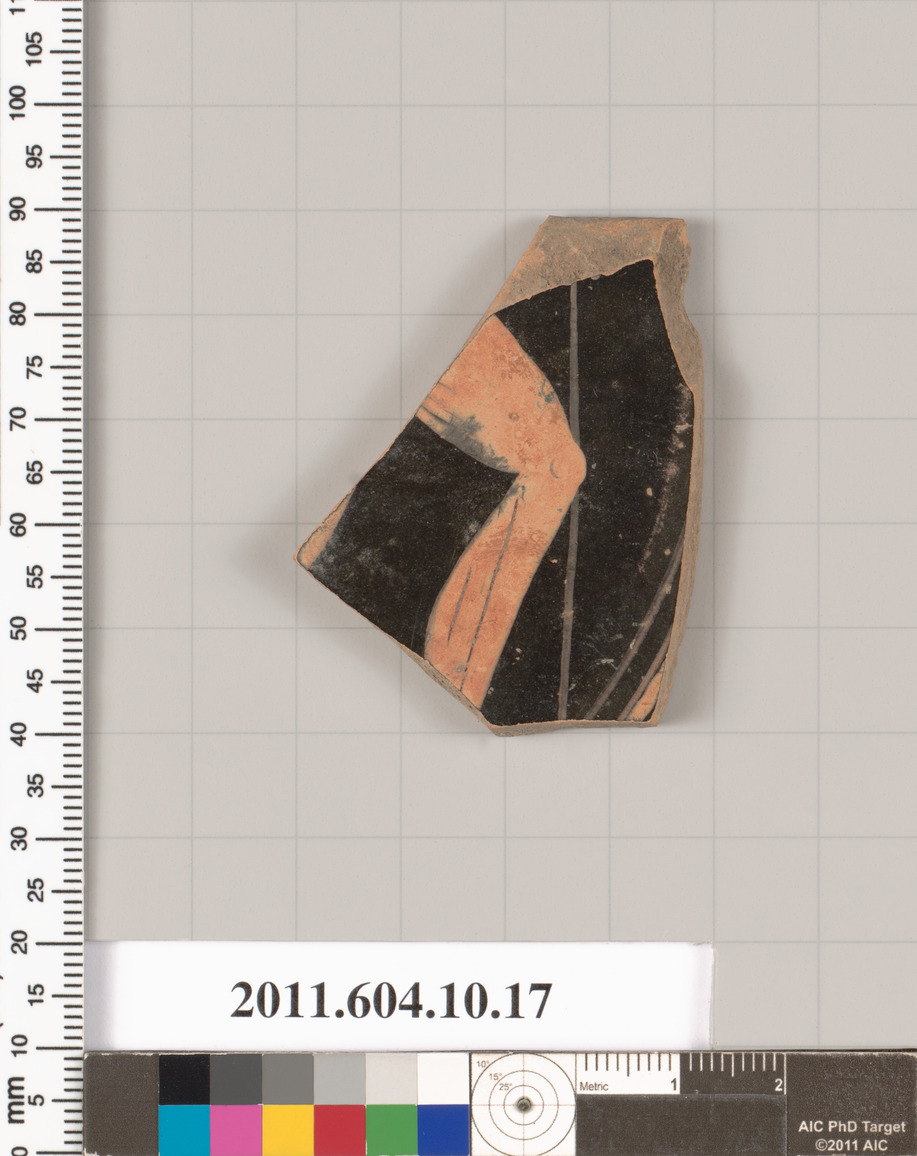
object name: kylix fragment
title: Terracotta fragment of a kylix (drinking cup)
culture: etruscan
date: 434-368 BCE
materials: terracotta